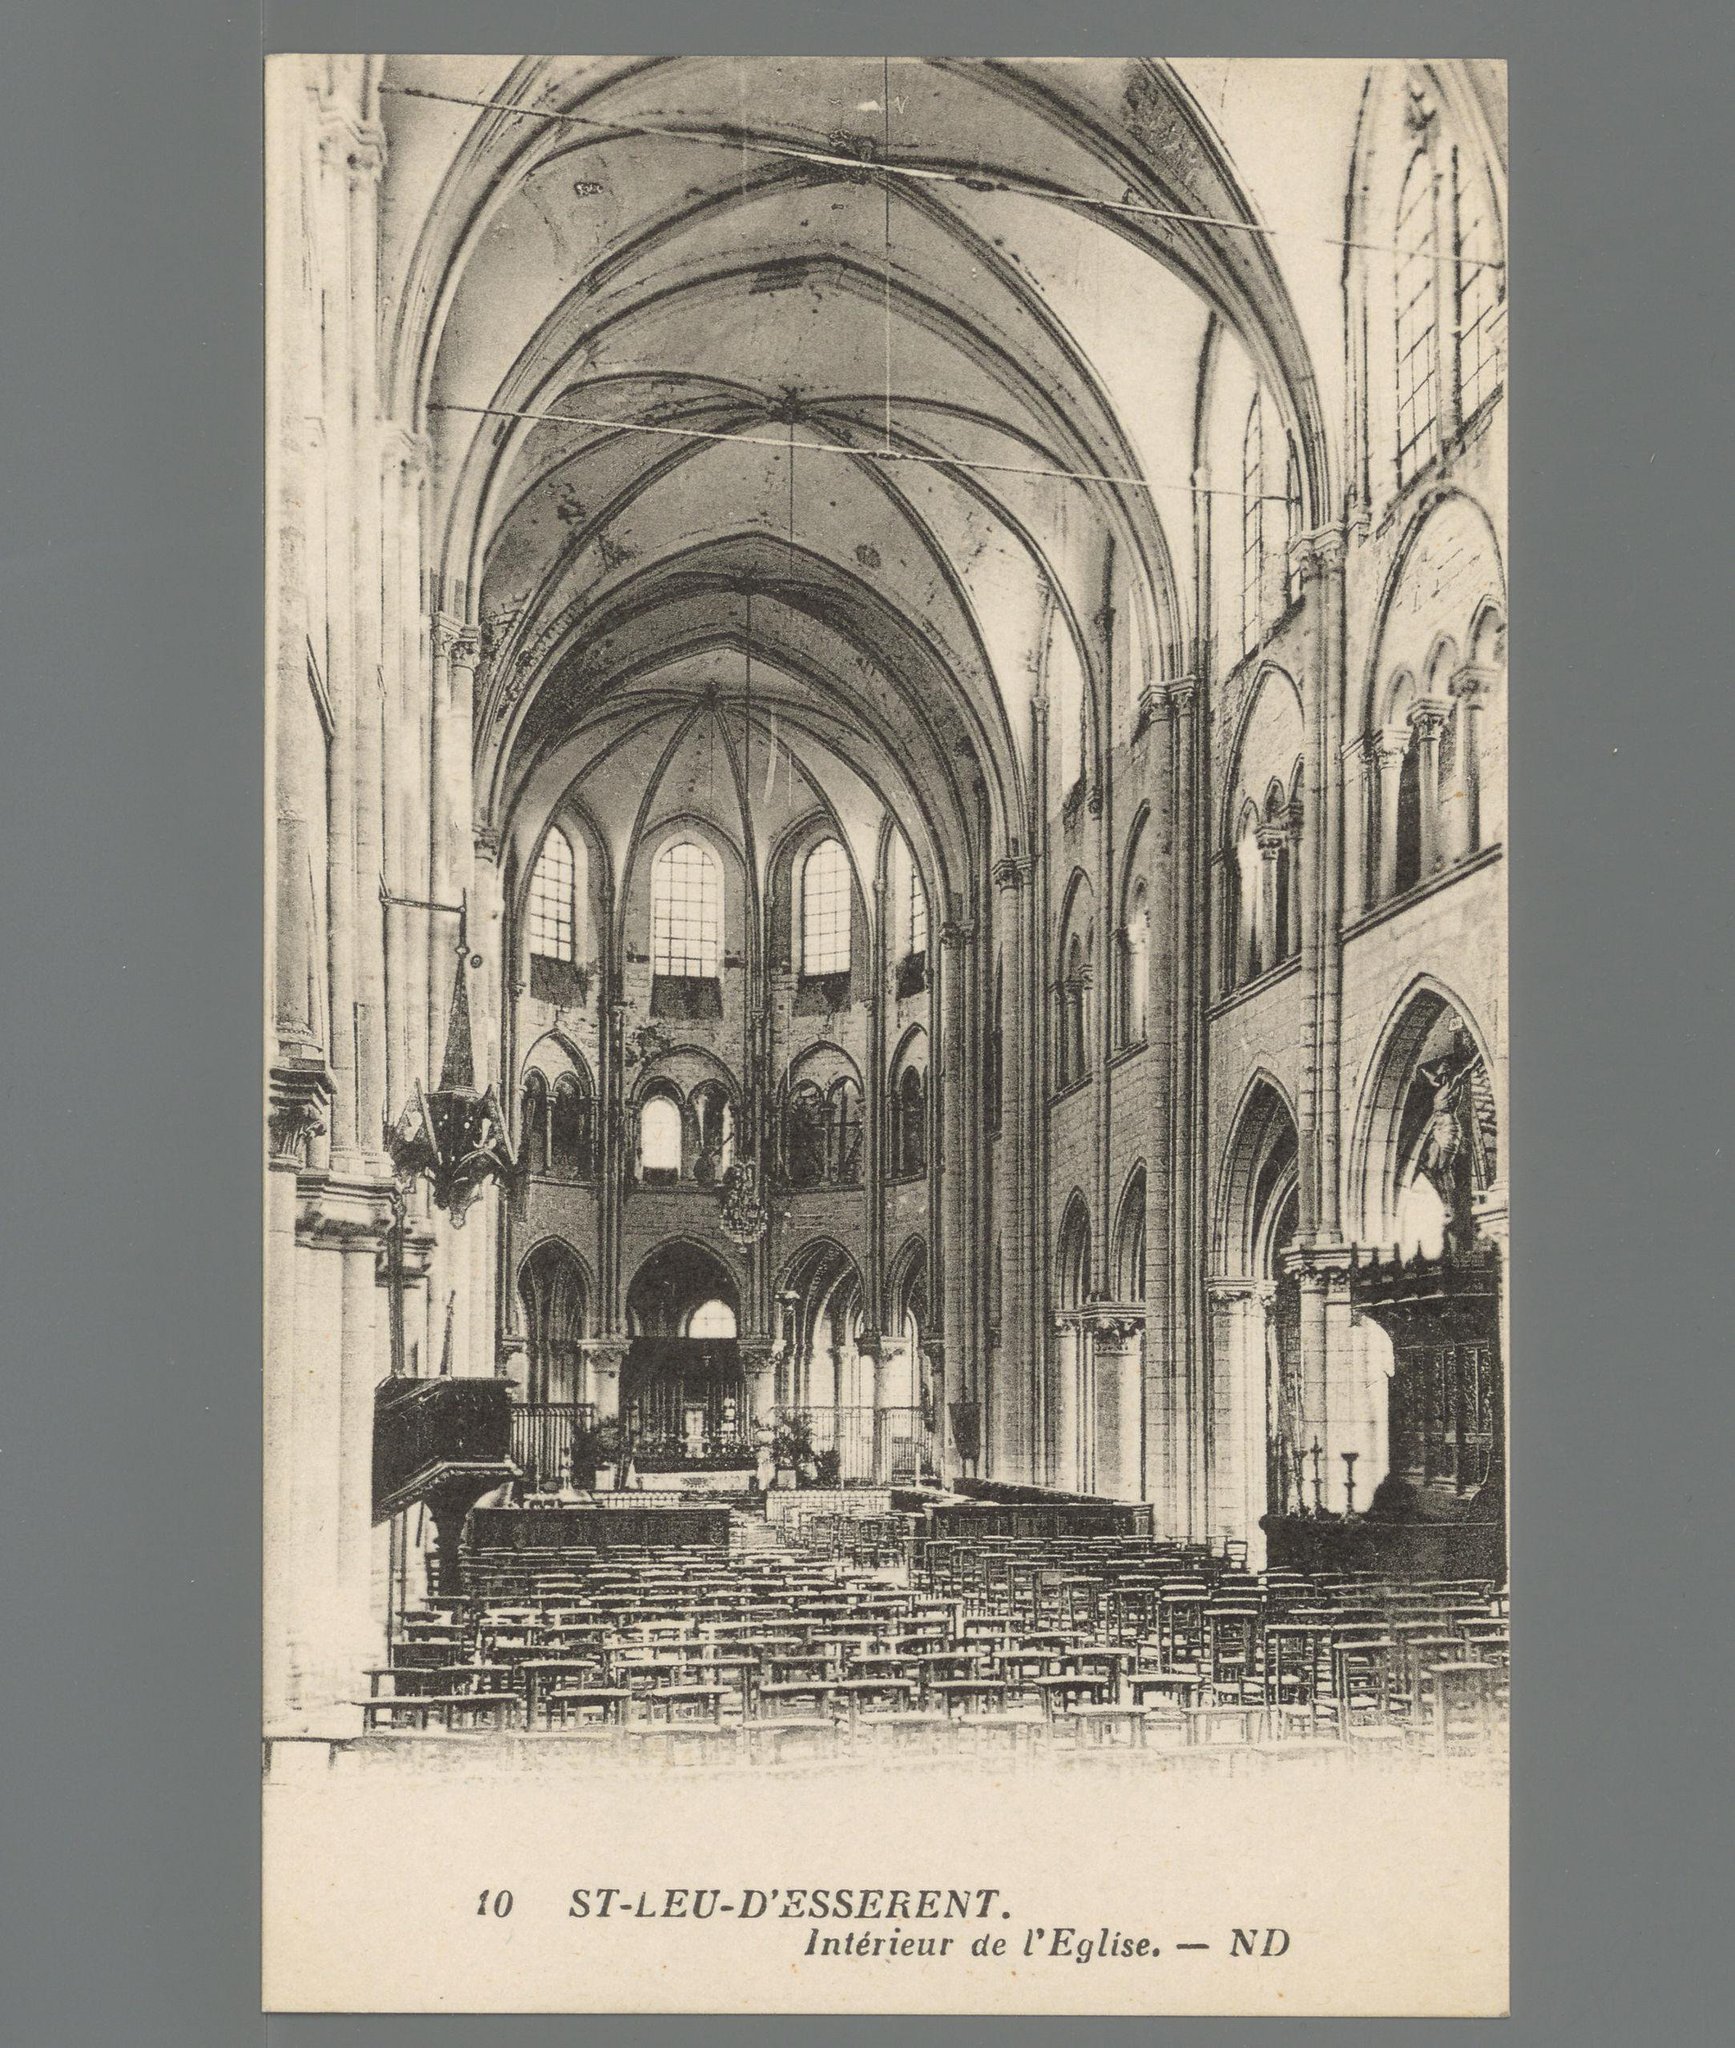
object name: ansichtkaart, prentbriefkaart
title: St-Leu-d'Esserent - Intérieur de l'Eglise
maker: Anonymous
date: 1920-1932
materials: cardboard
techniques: photograph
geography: saint-leu-d'esserent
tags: interior of church